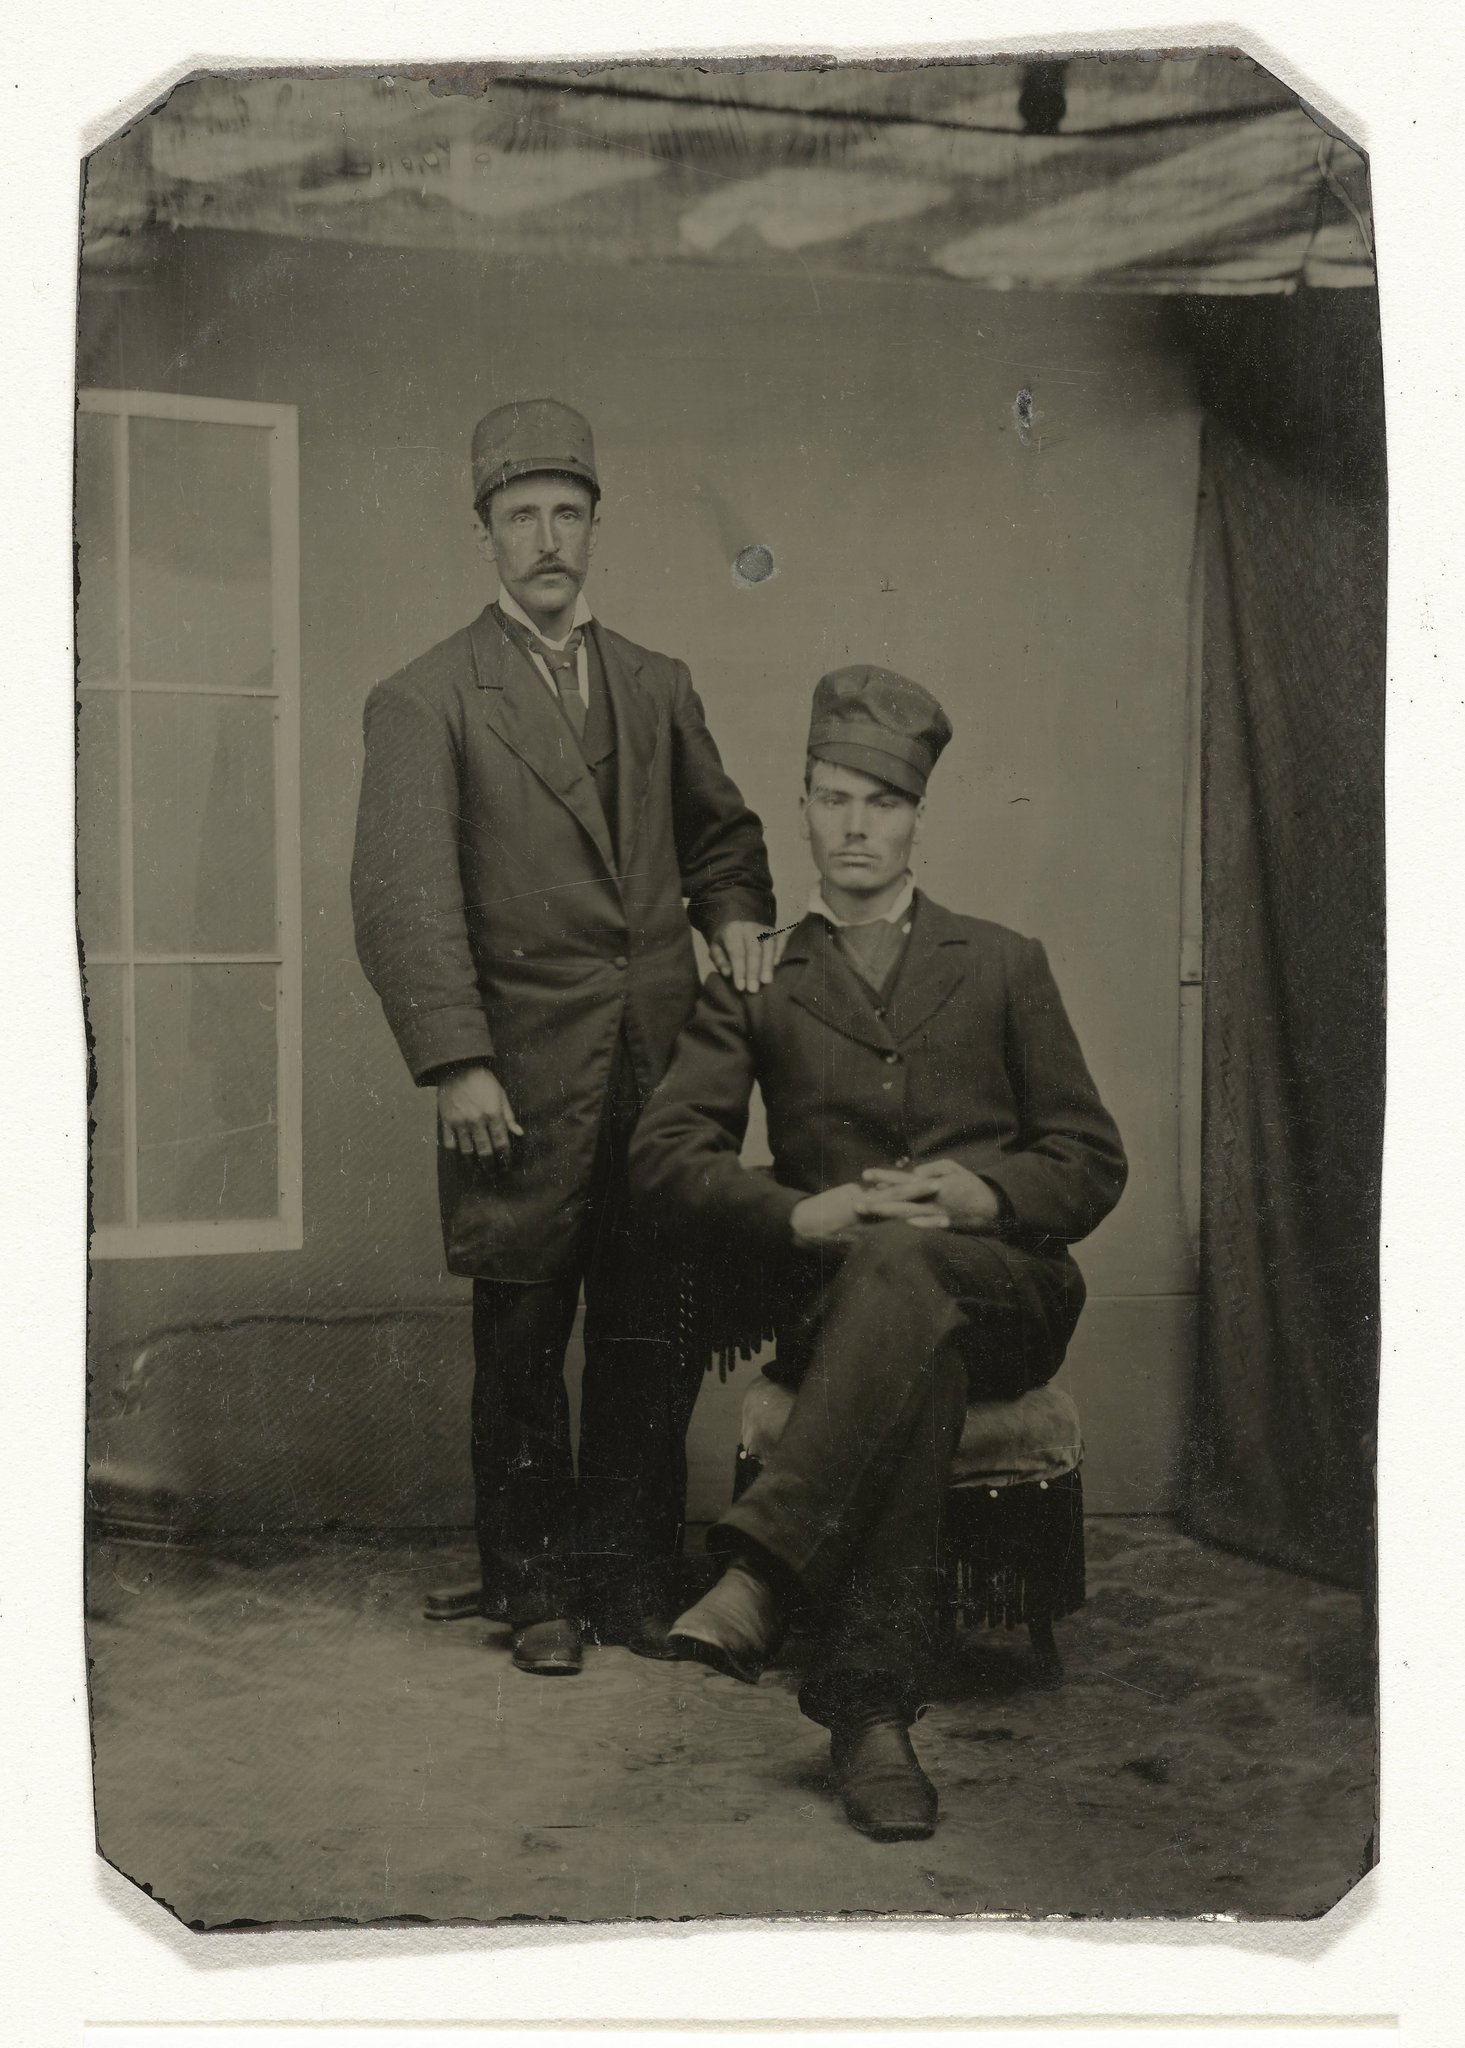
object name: photograph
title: Portrait of two men in a studio in front of a painted backdrop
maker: Anonymous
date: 1880-1900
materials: metal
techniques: ferrotyping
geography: united states